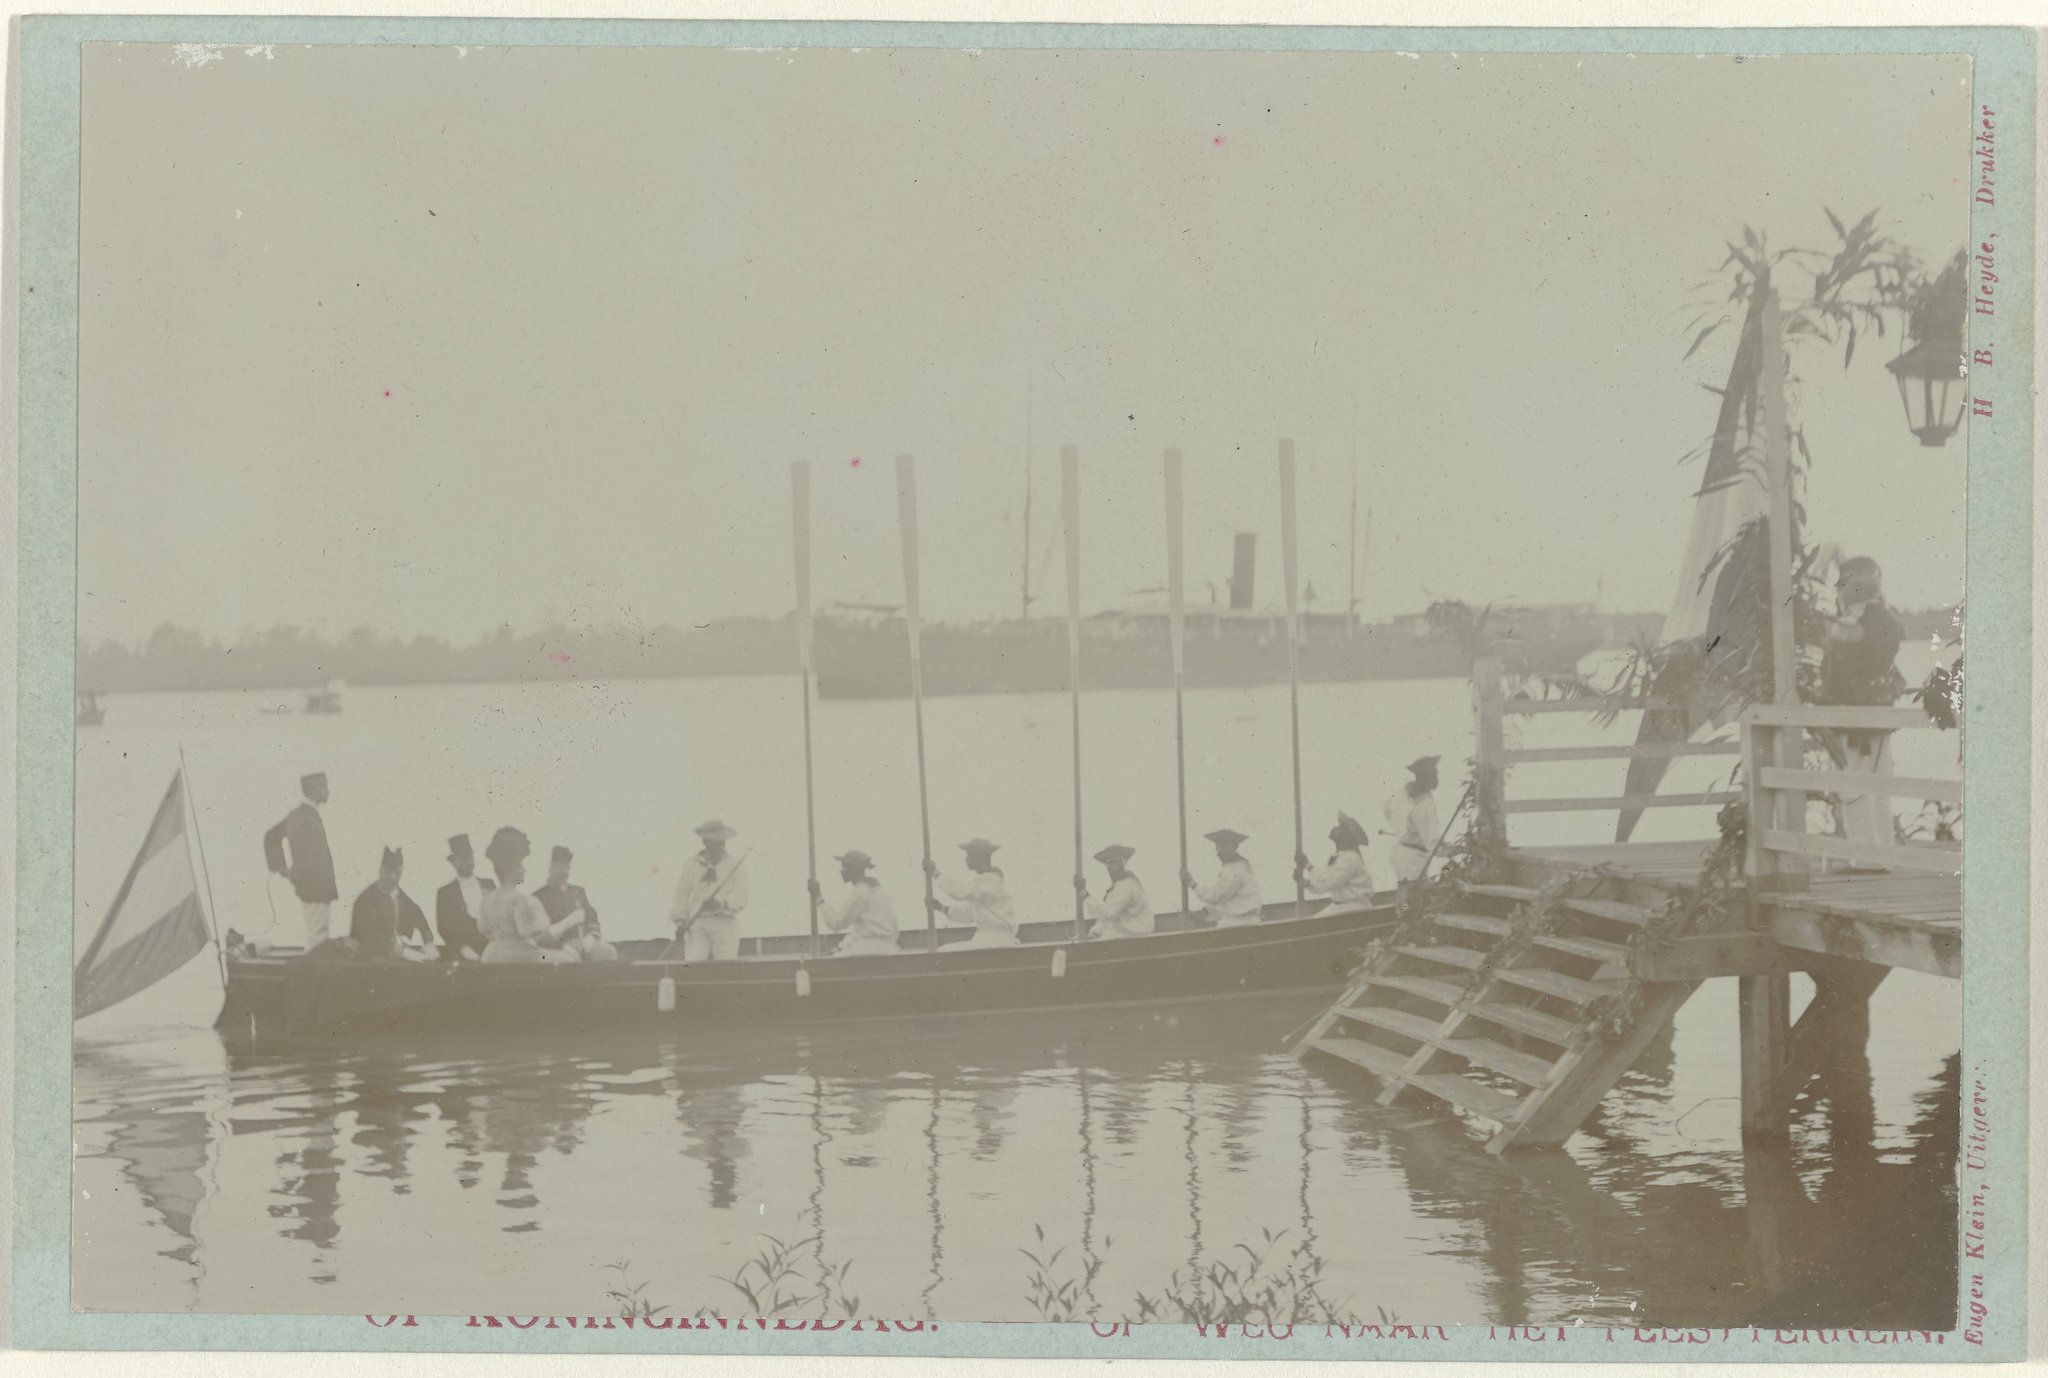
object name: photograph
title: Op Koninginnedag. Op weg naar het feestterrein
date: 1903-1908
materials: cardboard, photographic support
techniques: photography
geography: paramaribo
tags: meppel, rechter, jurist, gouverneur, procureur-generaal, petrus hofstede crull, paramaribo (stad), koninginnedag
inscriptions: inscription: ‘OP KONINGINNEDAG. Op weg naar het feest terrein.’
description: Een boot vaart weg van de steiger. Aan boord Hofstede Crull en zijn vrouw. Hofstede Crull was op dat moment waarnemend gouverneur van Suriname. Koninginnedag te Paramaribo. Onderaan de kaart waar de foto op is geplakt een opschrift.